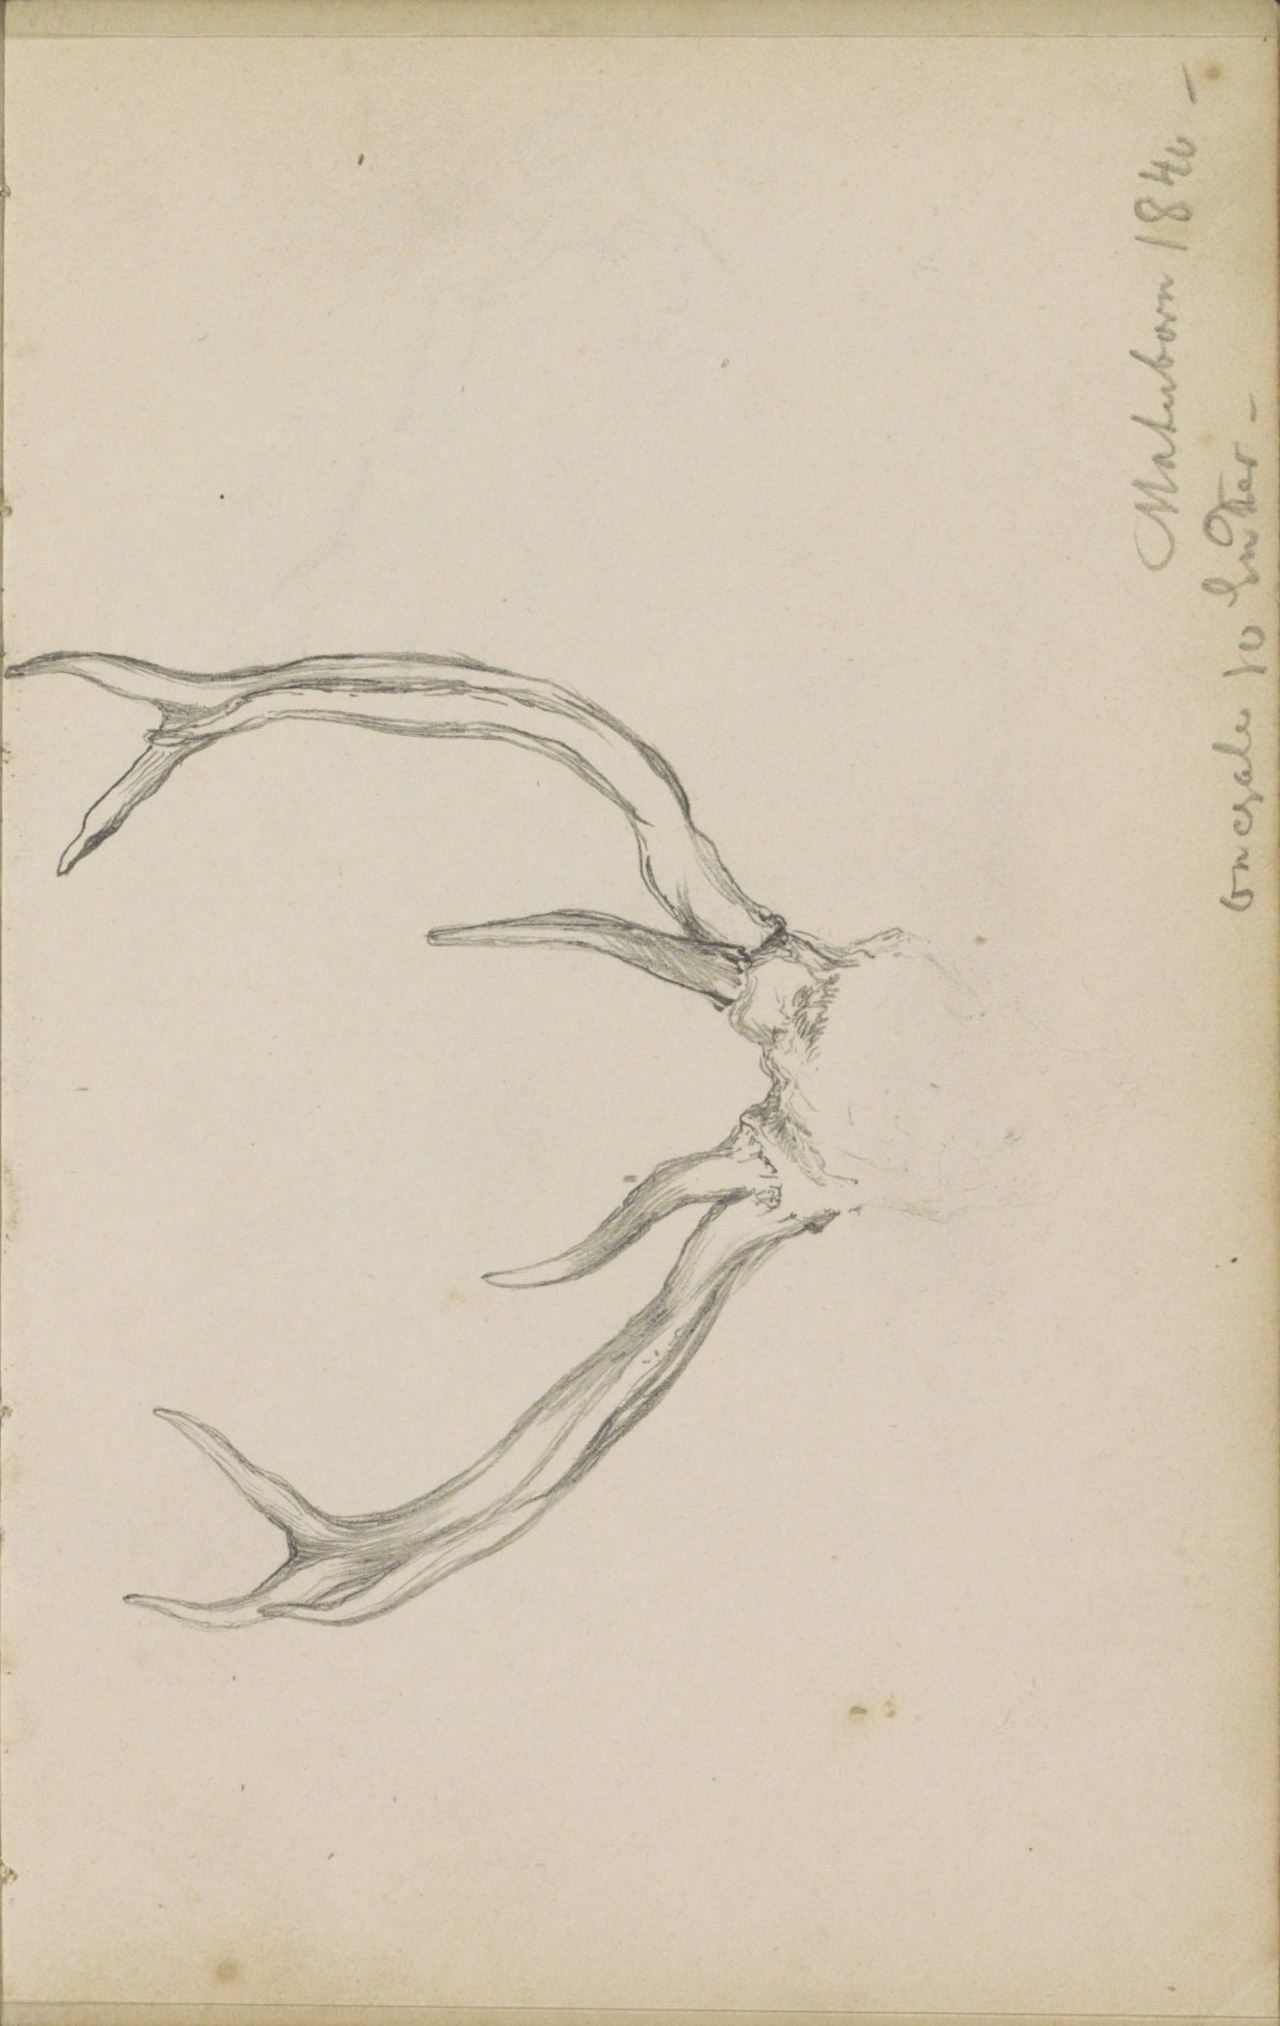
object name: sketchbook leaf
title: Hertengewei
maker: johannes tavenraat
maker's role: draughtsman, painter, print maker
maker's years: 1809-1881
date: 1840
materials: paper, pencil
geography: materborn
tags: hoofed animals: deer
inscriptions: date and inscription: ‘Materborn 1840-/ [....] herder’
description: Blad 51 recto uit een schetsboek met 73 bladen.